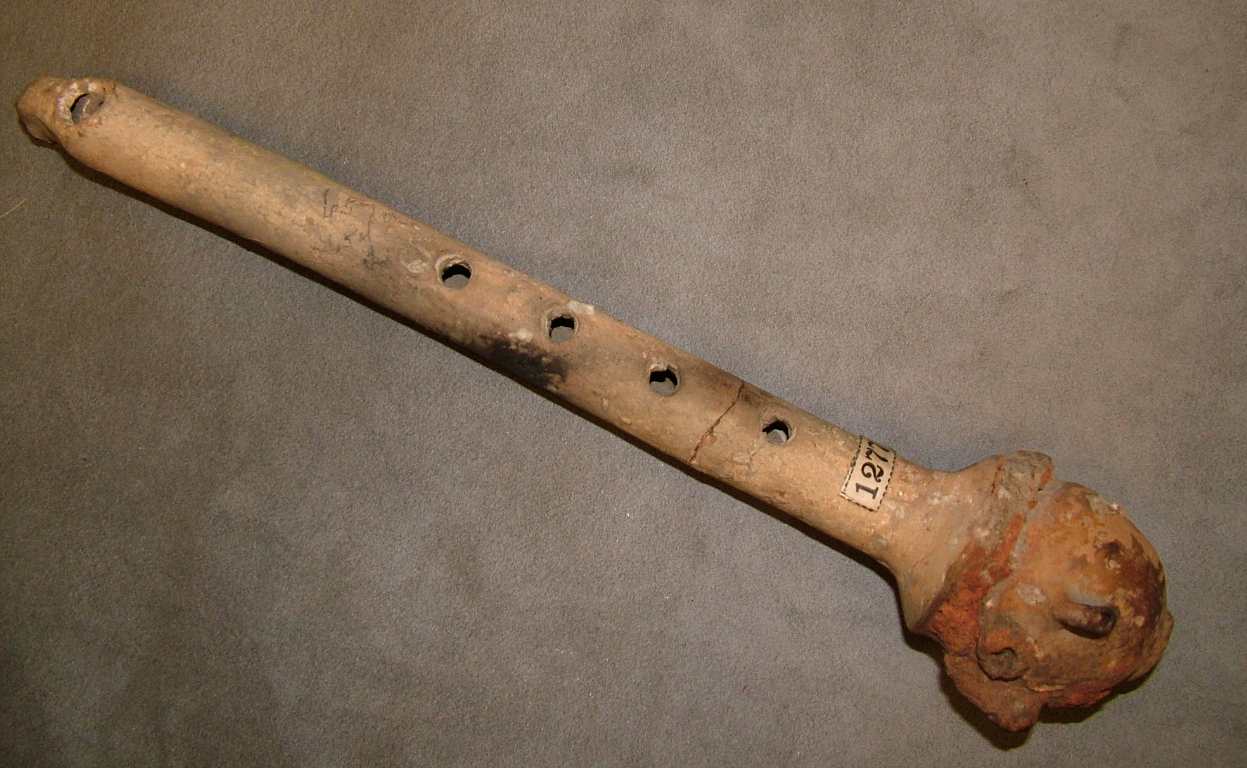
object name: pottery flute and rattle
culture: mexican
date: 1467-1500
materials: clay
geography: mexico